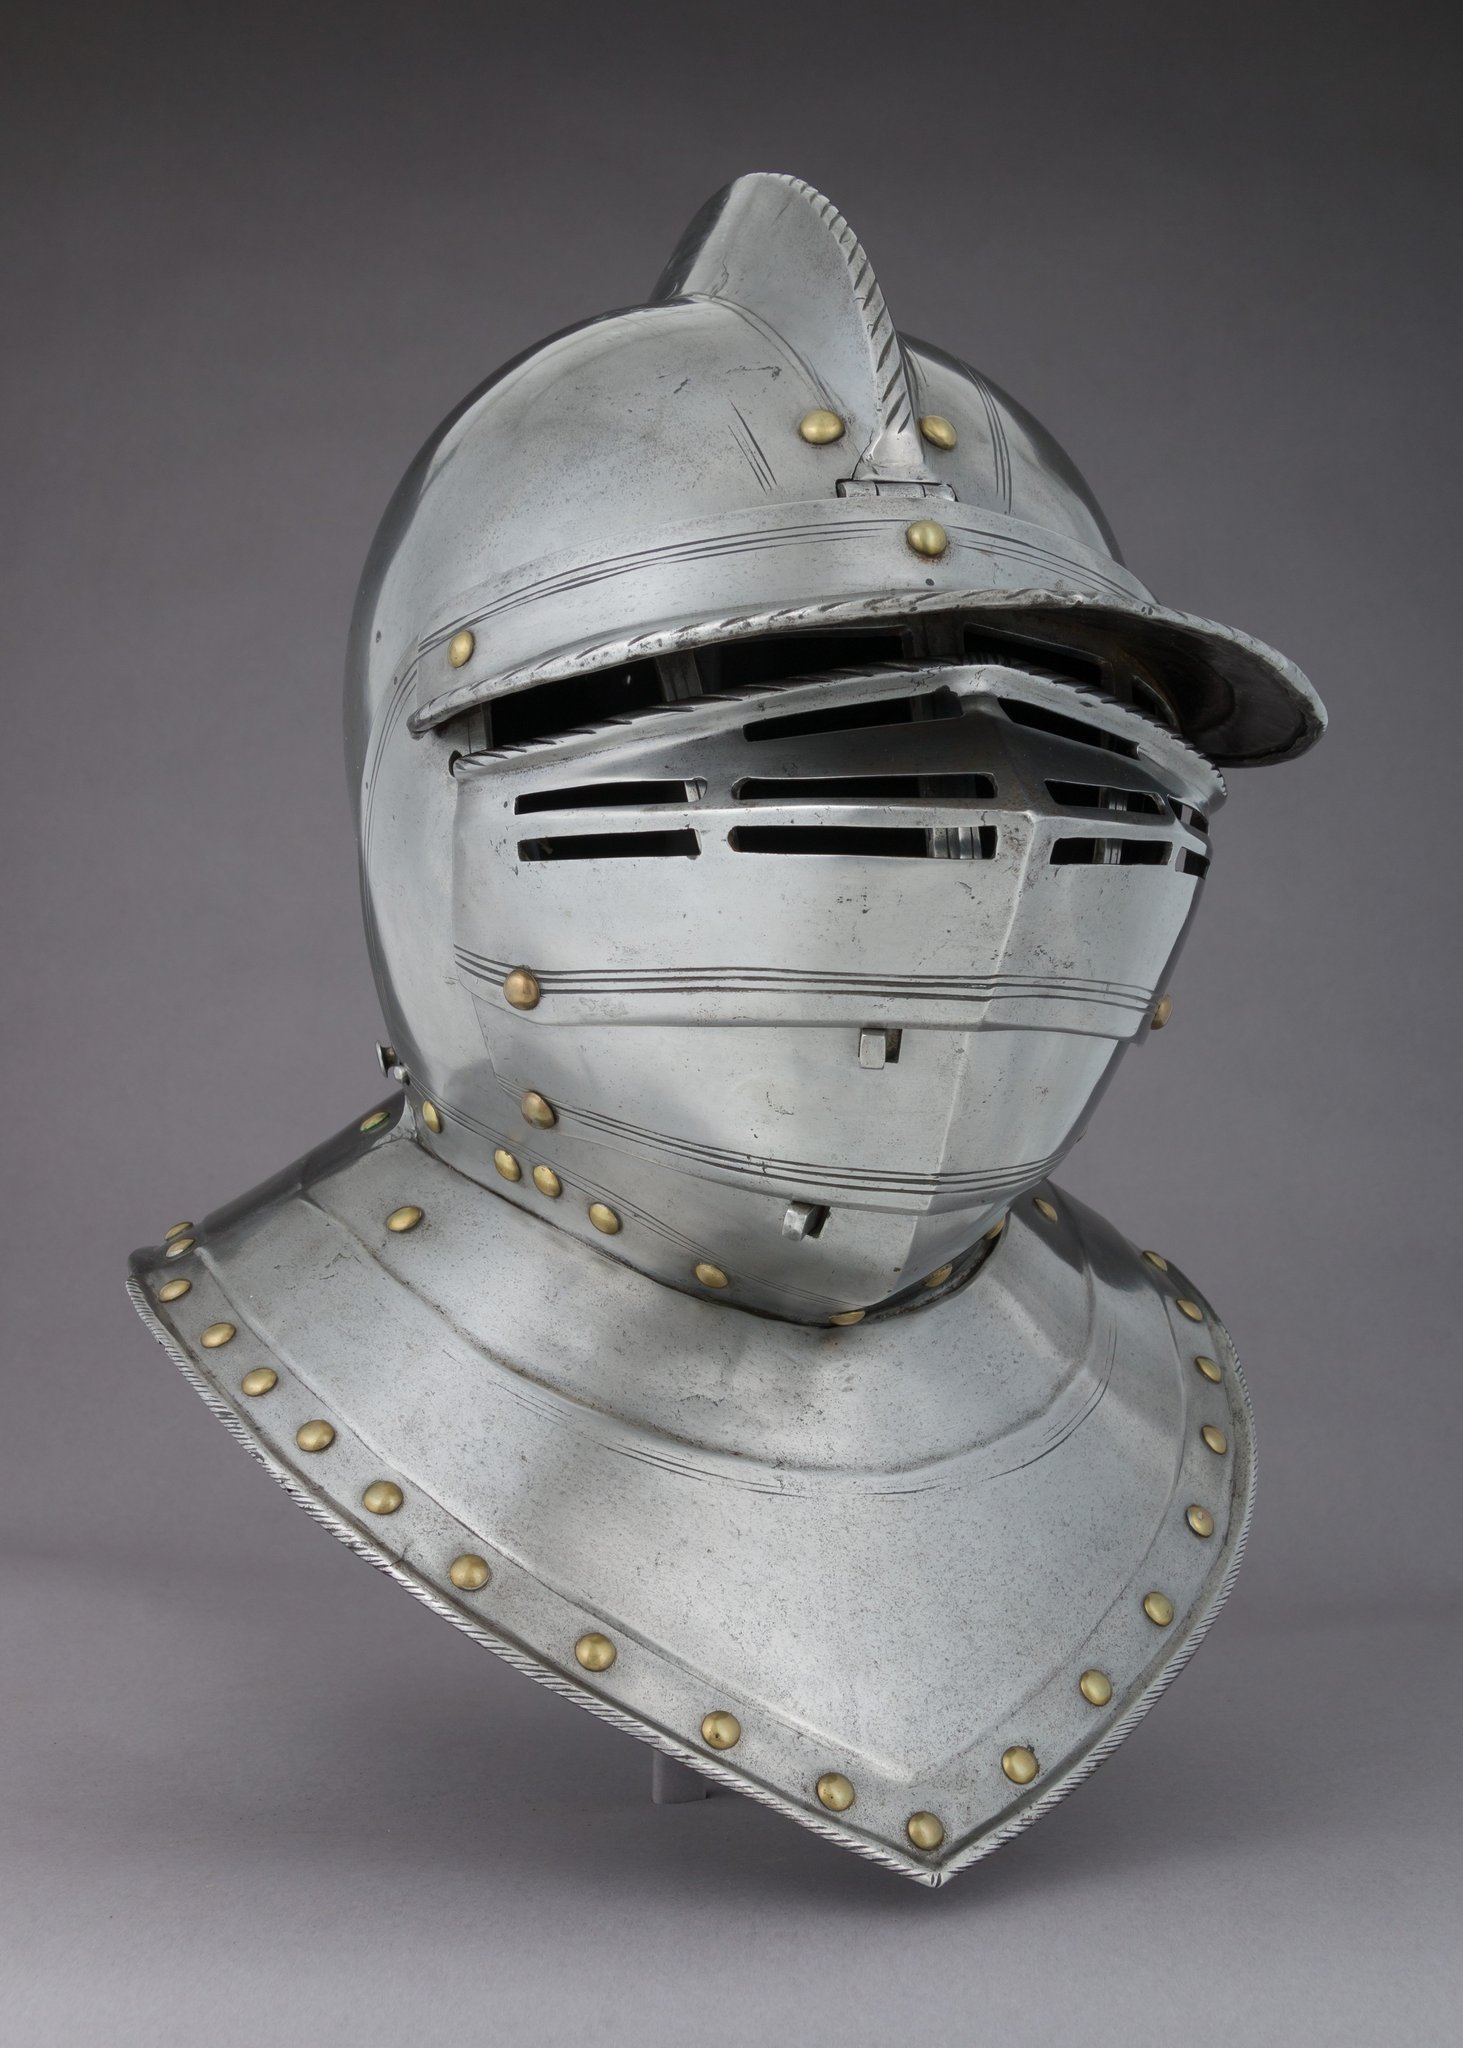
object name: closed burgonet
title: Closed Burgonet with Falling Buffe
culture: british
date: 1590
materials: brass, steel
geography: england